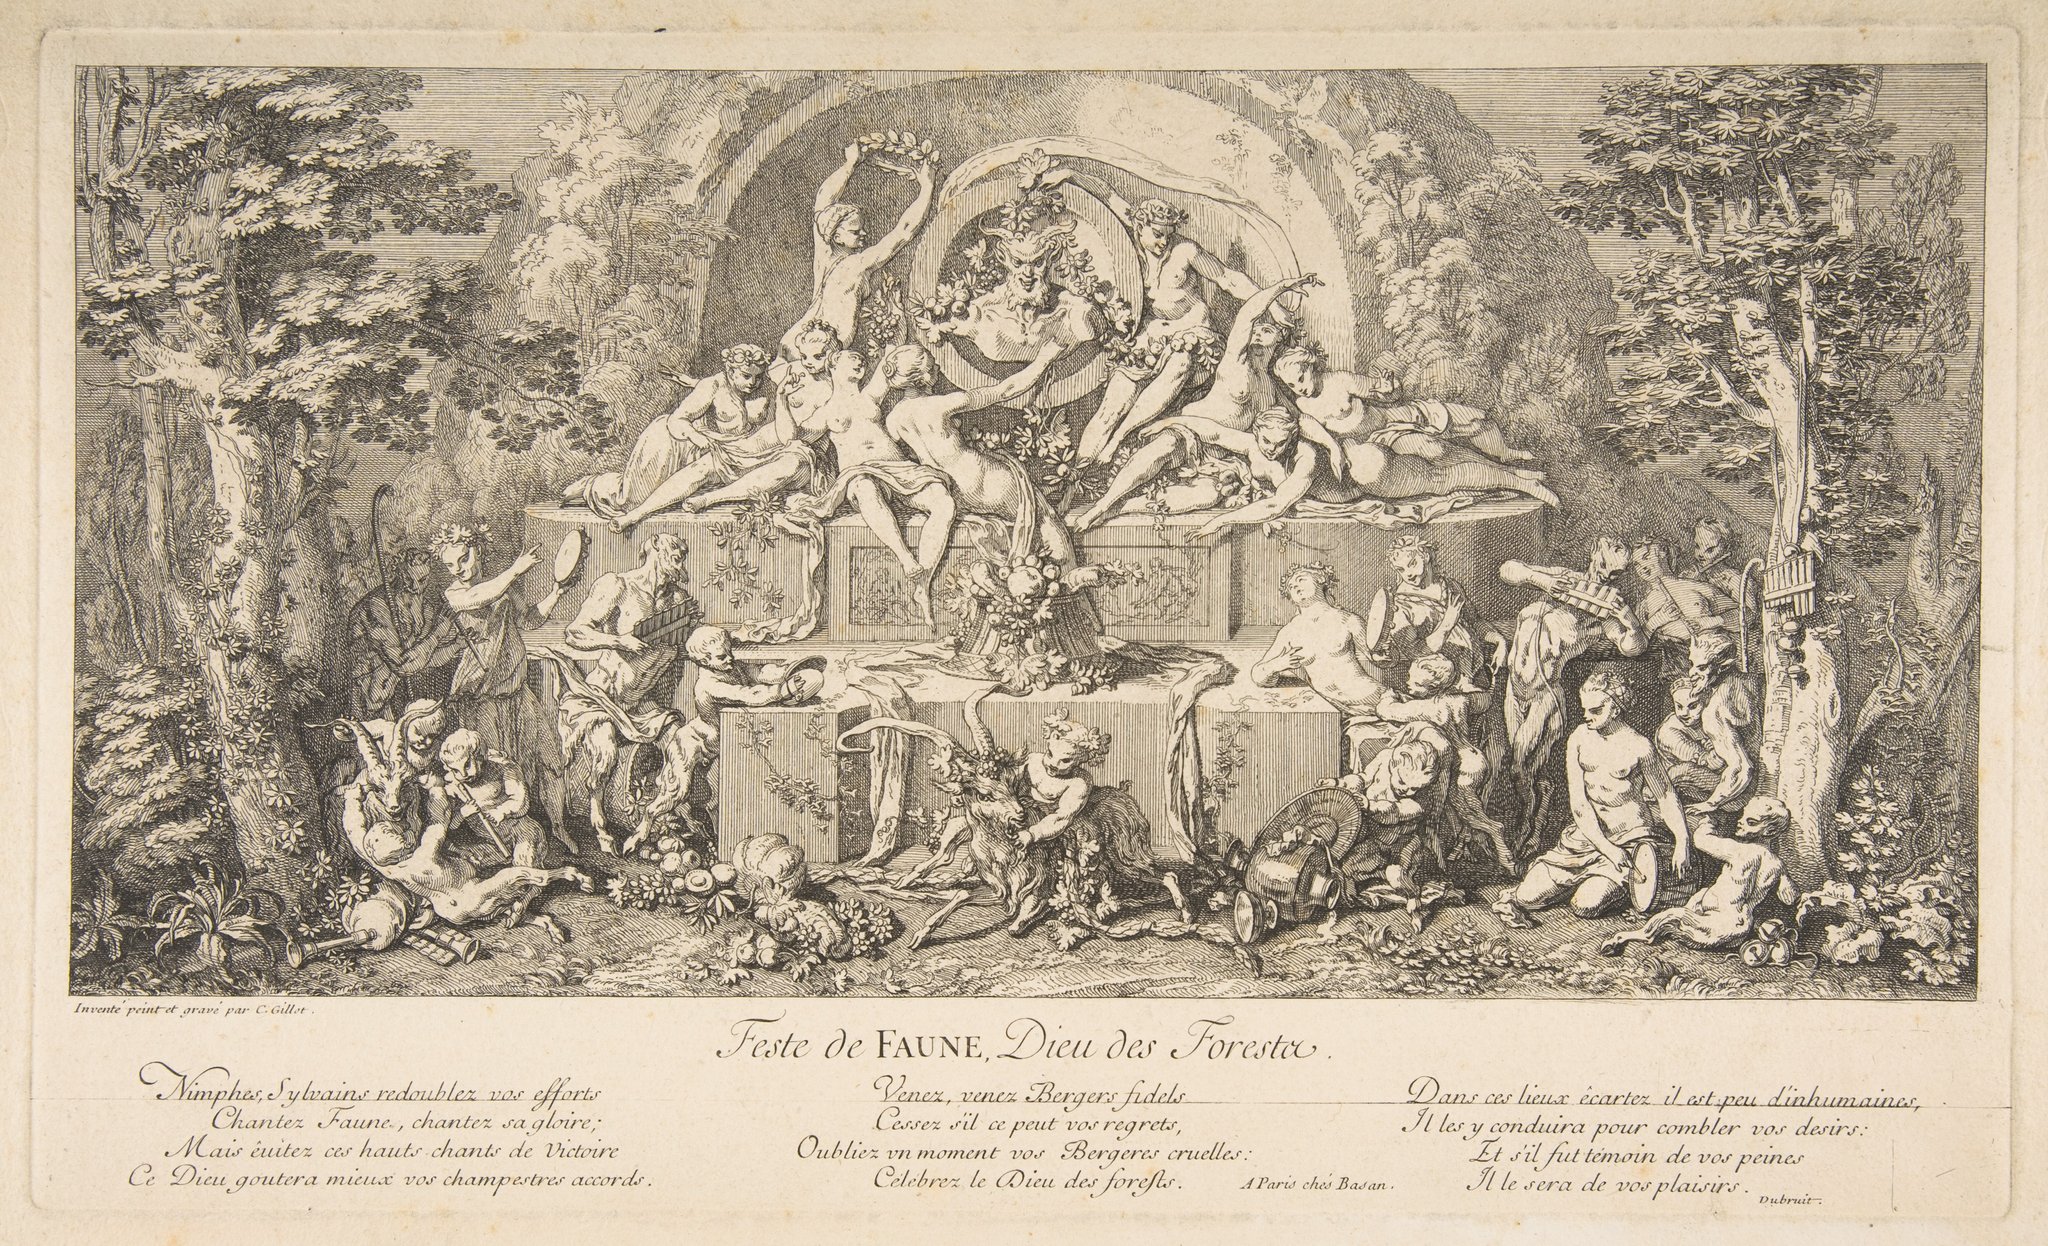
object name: print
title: The Feast of the Faun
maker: claude gillot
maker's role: artist and engraver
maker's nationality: french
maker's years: 1673-1722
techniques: etching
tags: musical instruments,female nudes,fauns